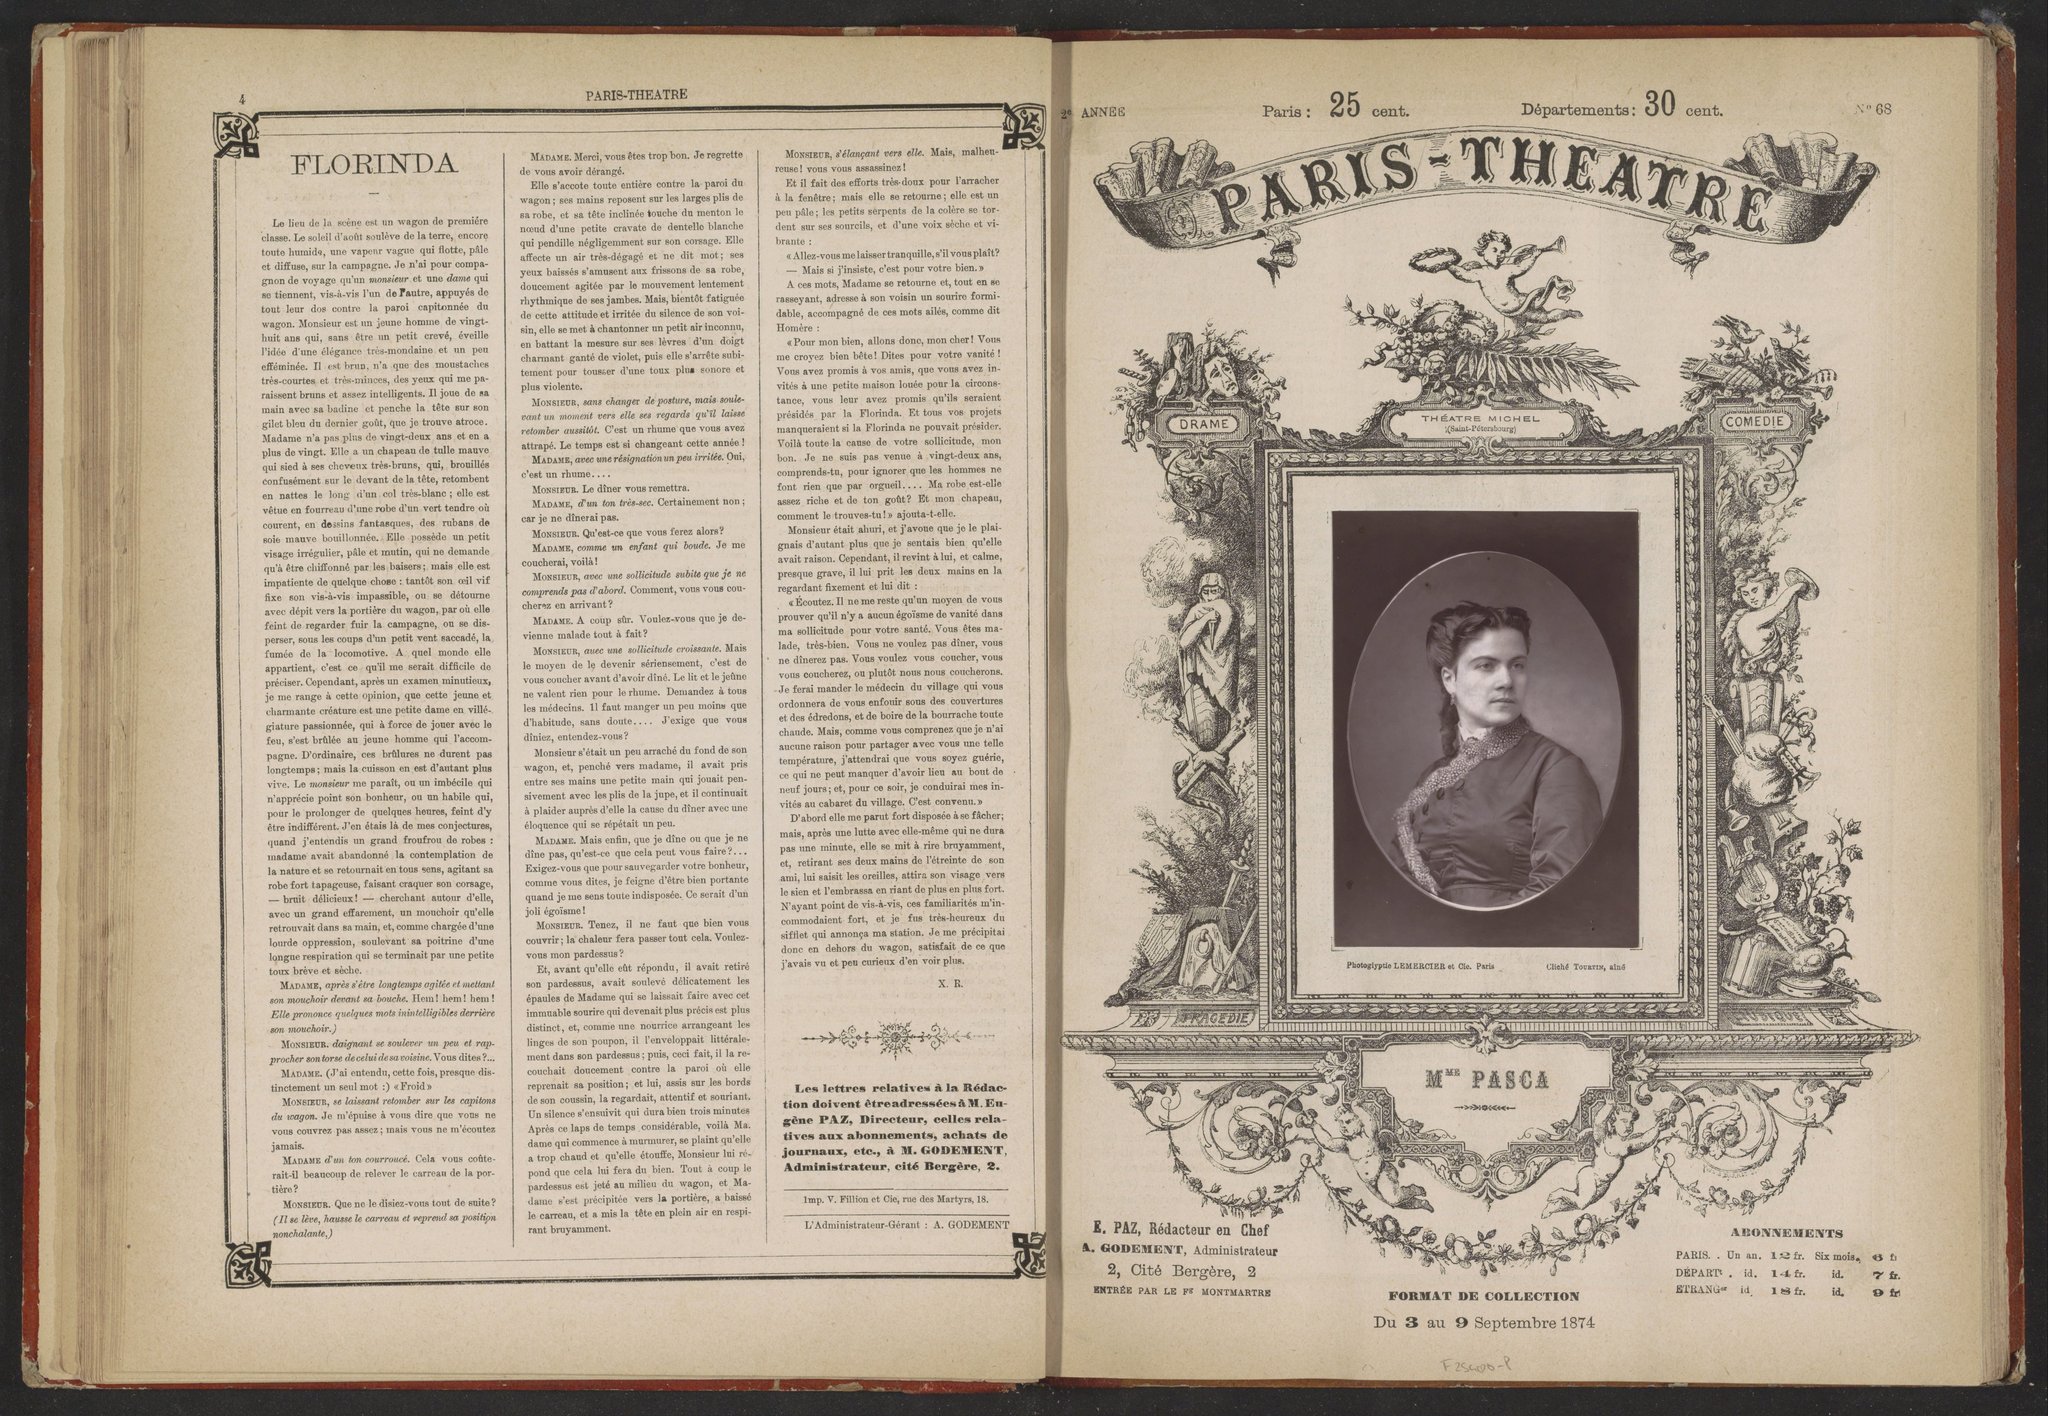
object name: page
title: Mme Pasca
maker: j. tourtin (lainé)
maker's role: fotograaf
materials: paper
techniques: woodburytype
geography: france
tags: lyon, paris, portrait of actor, actress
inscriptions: inscription: ‘Du 3 au 9 Septembre 1874’, number: ‘No 68’